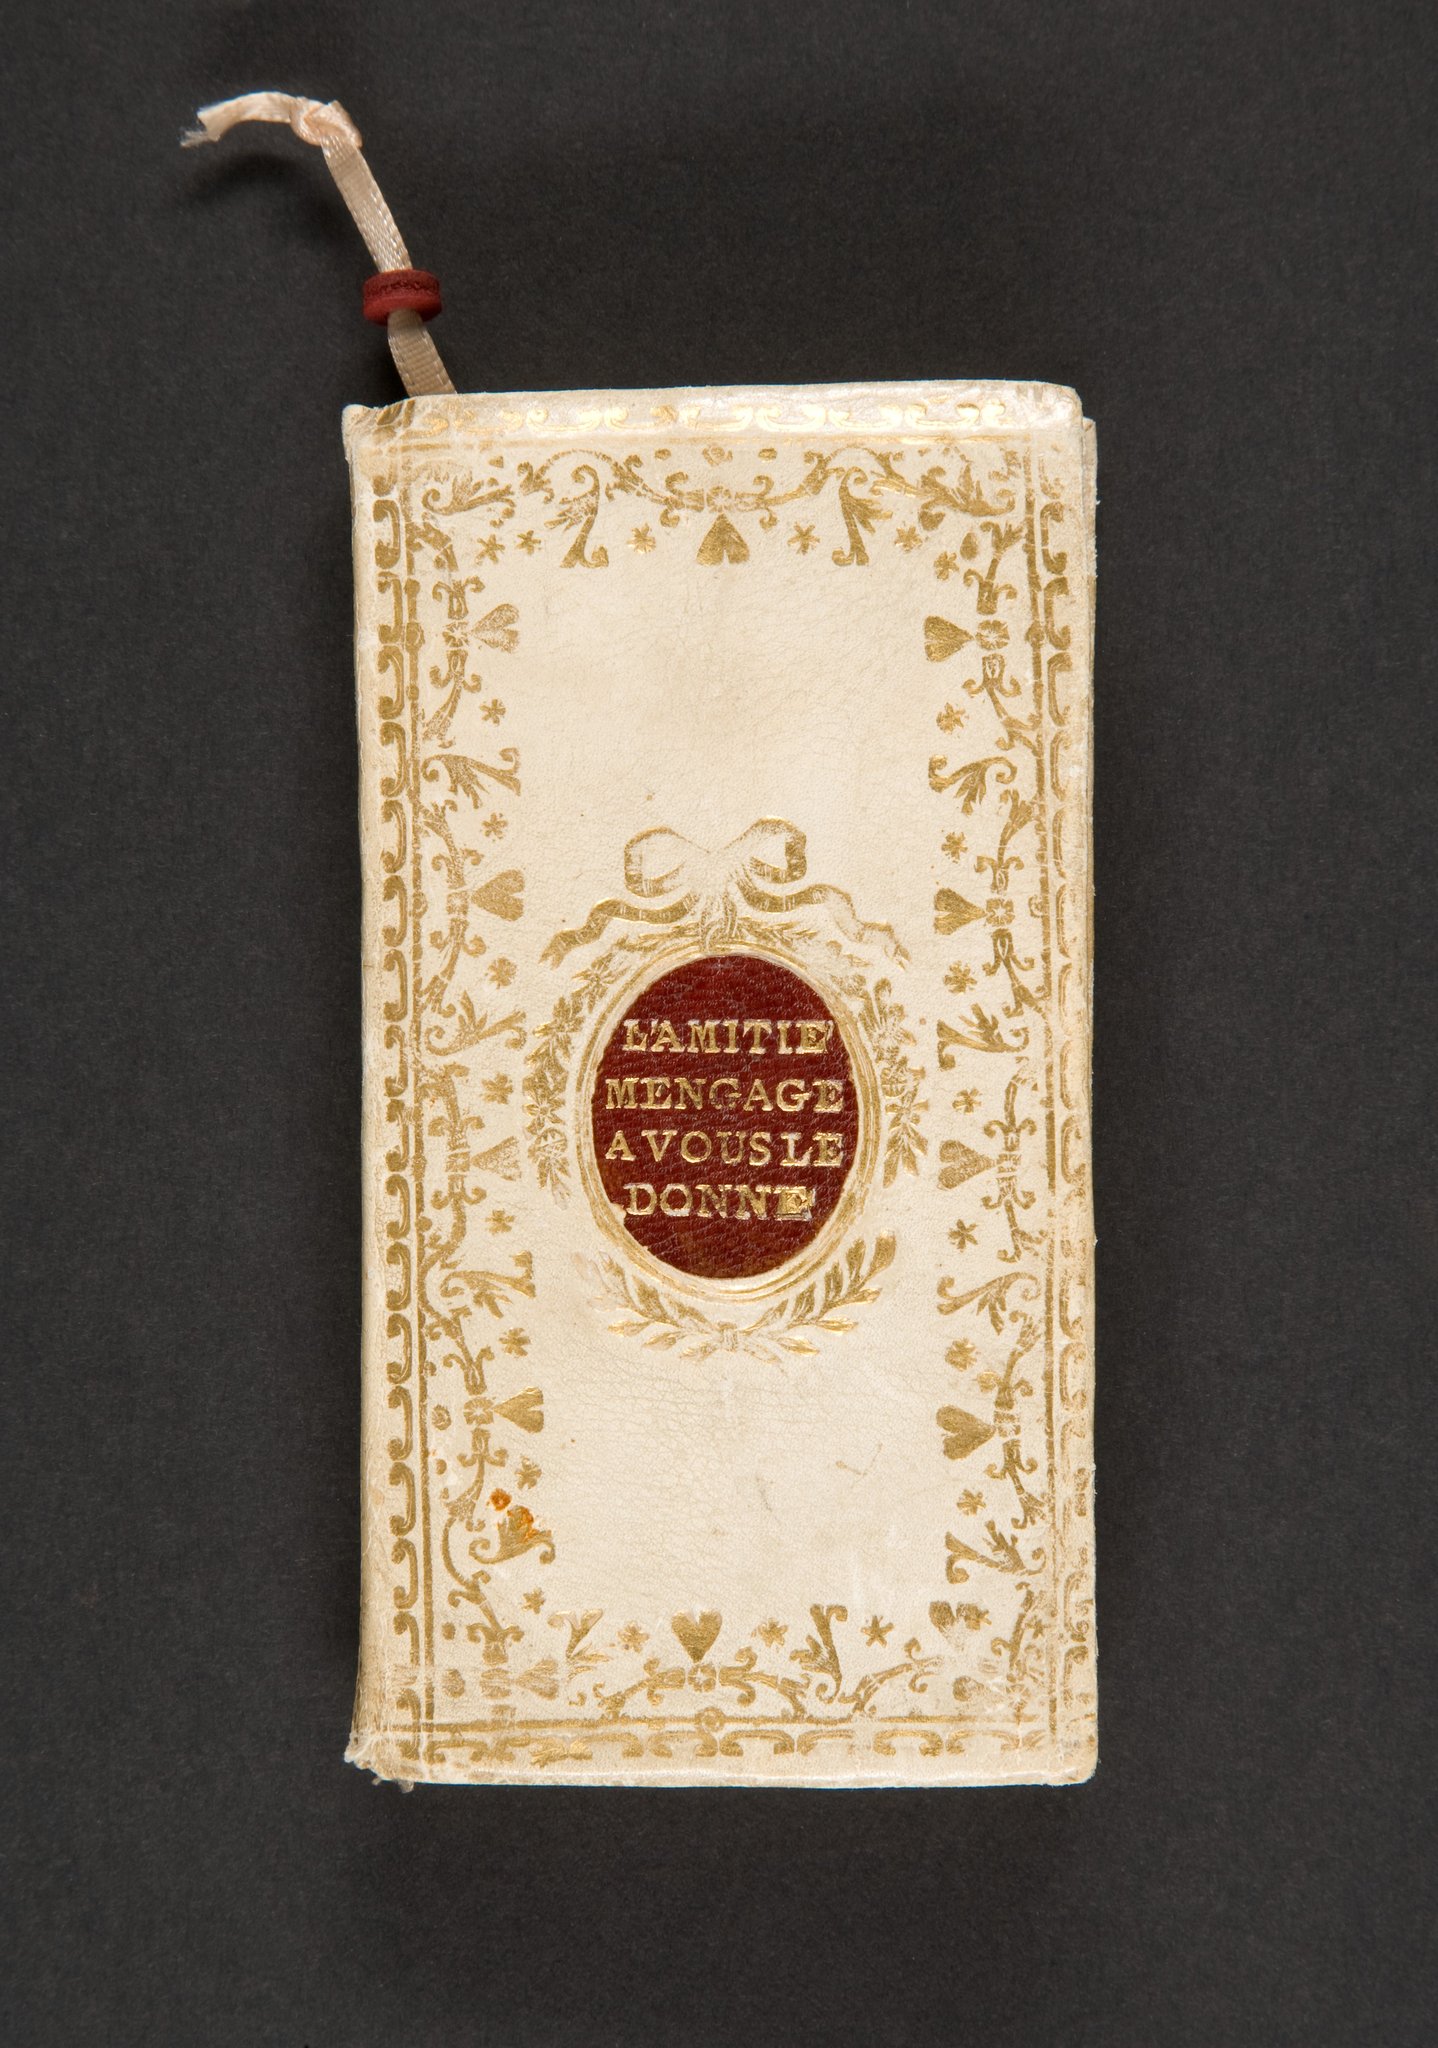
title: Almanach de Normandie pour l'année bissext. 1788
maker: la veuve besongne & fils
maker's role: publisher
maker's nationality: french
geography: france